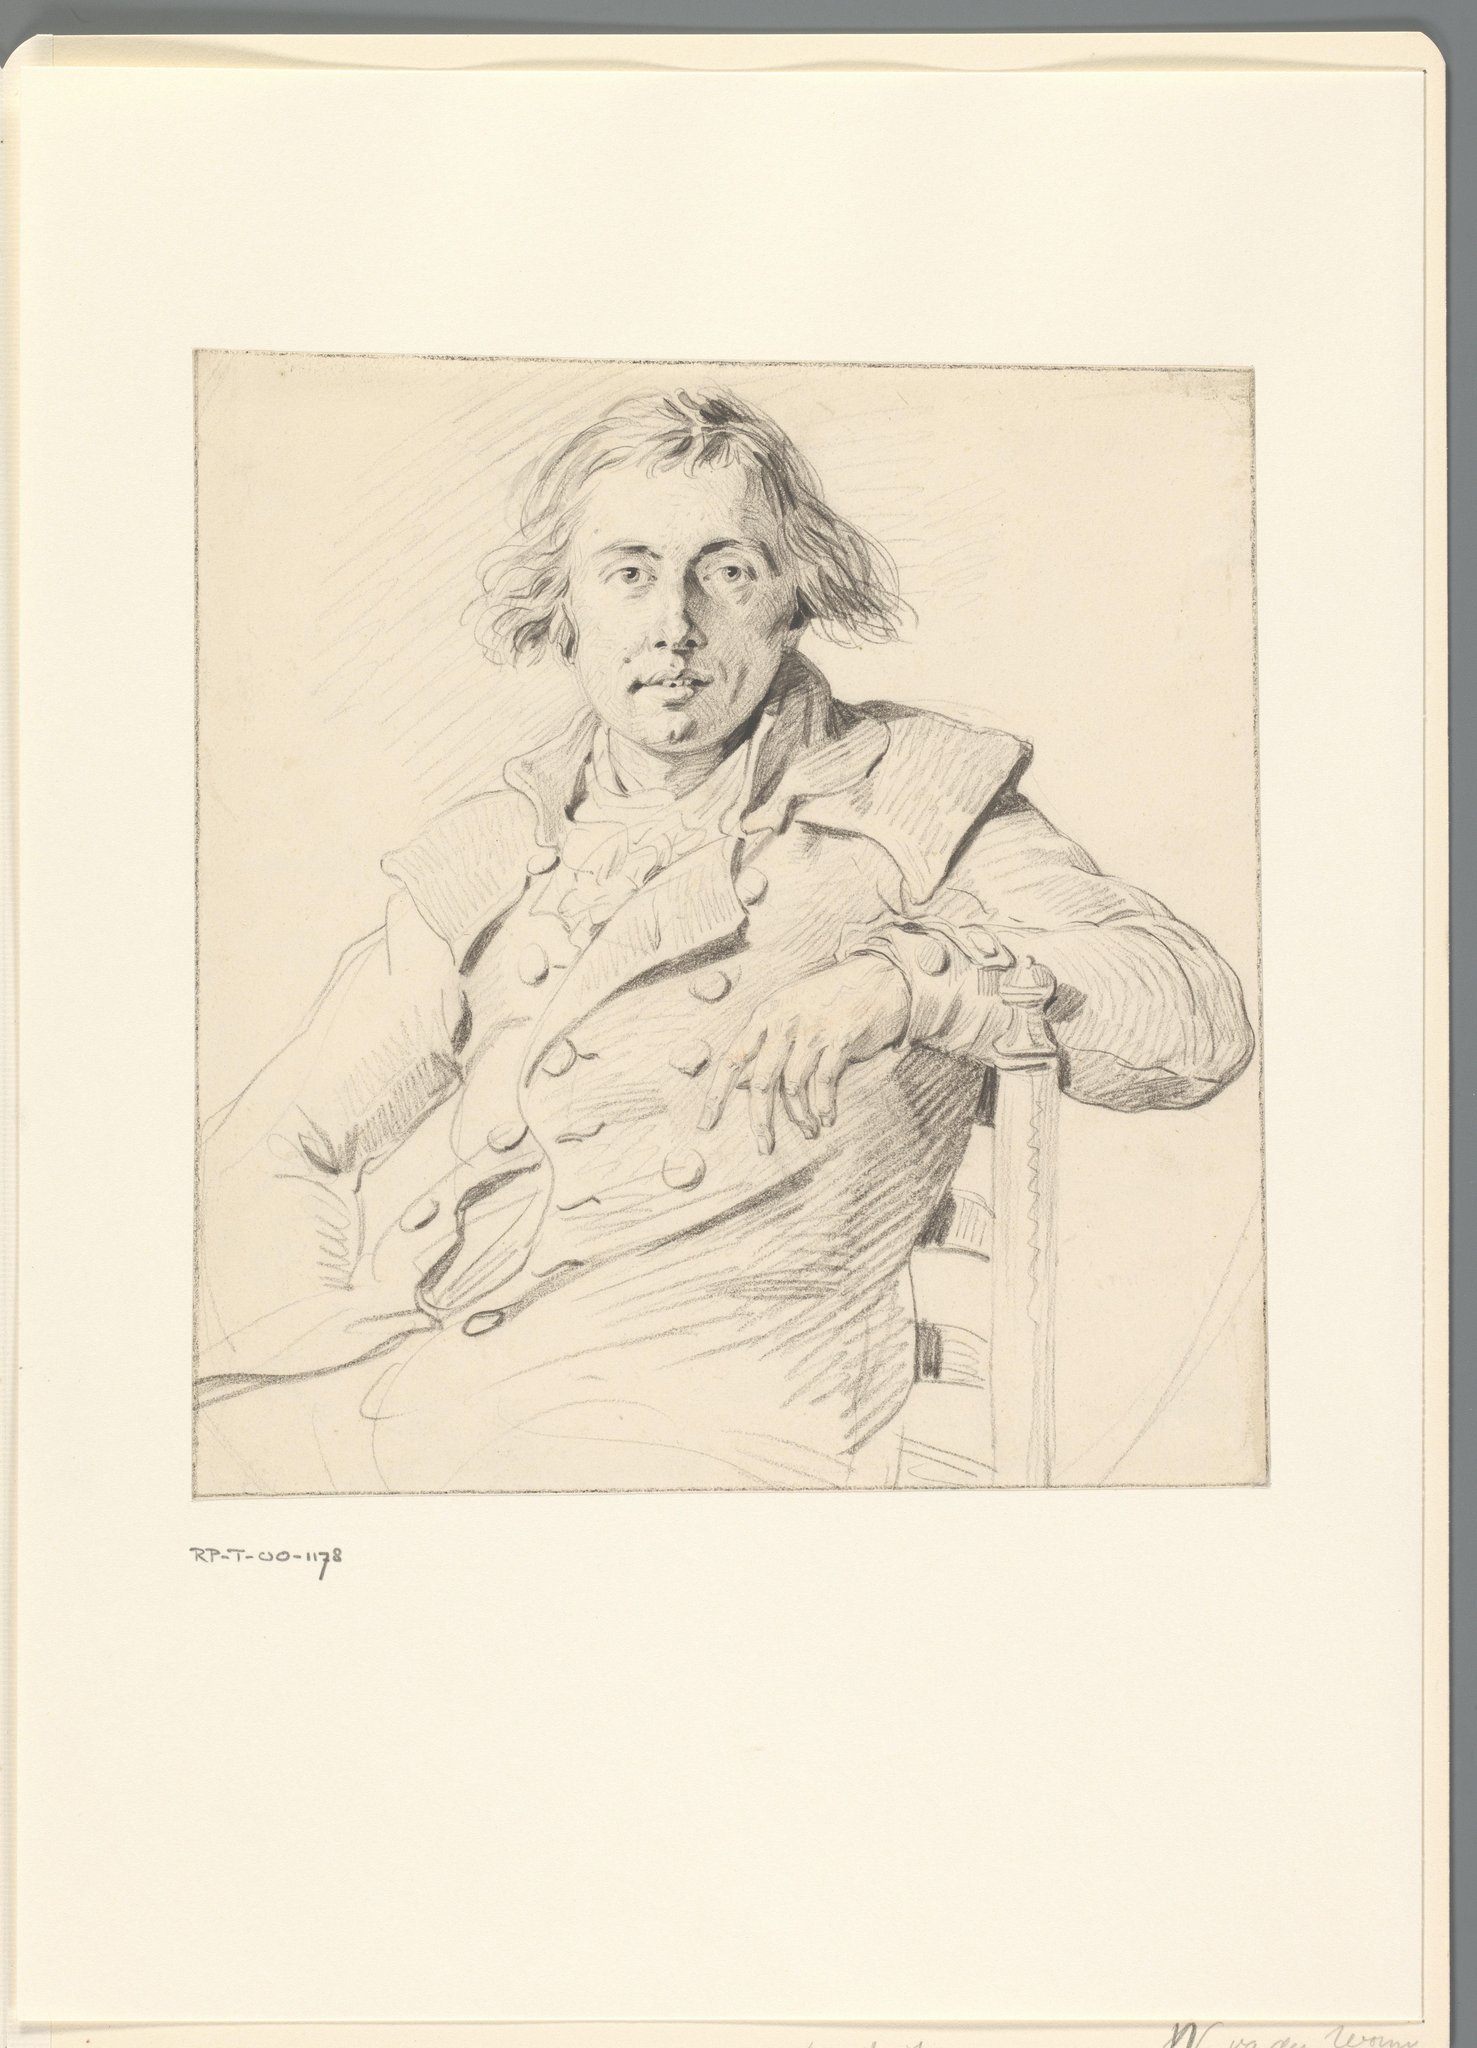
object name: drawing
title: Portret van Johannes Christiaan Janson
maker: nicolaas van der worm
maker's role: draughtsman, print maker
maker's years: 1757-1828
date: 1780-1820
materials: chalk, paper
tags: leiden, the hague, painter, print maker, draughtsman, johannes christiaan janson, historical persons, portrait, self-portrait of painter, portrait, self-portrait of artist, graphic artist, portrait, self-portrait of draughtsman